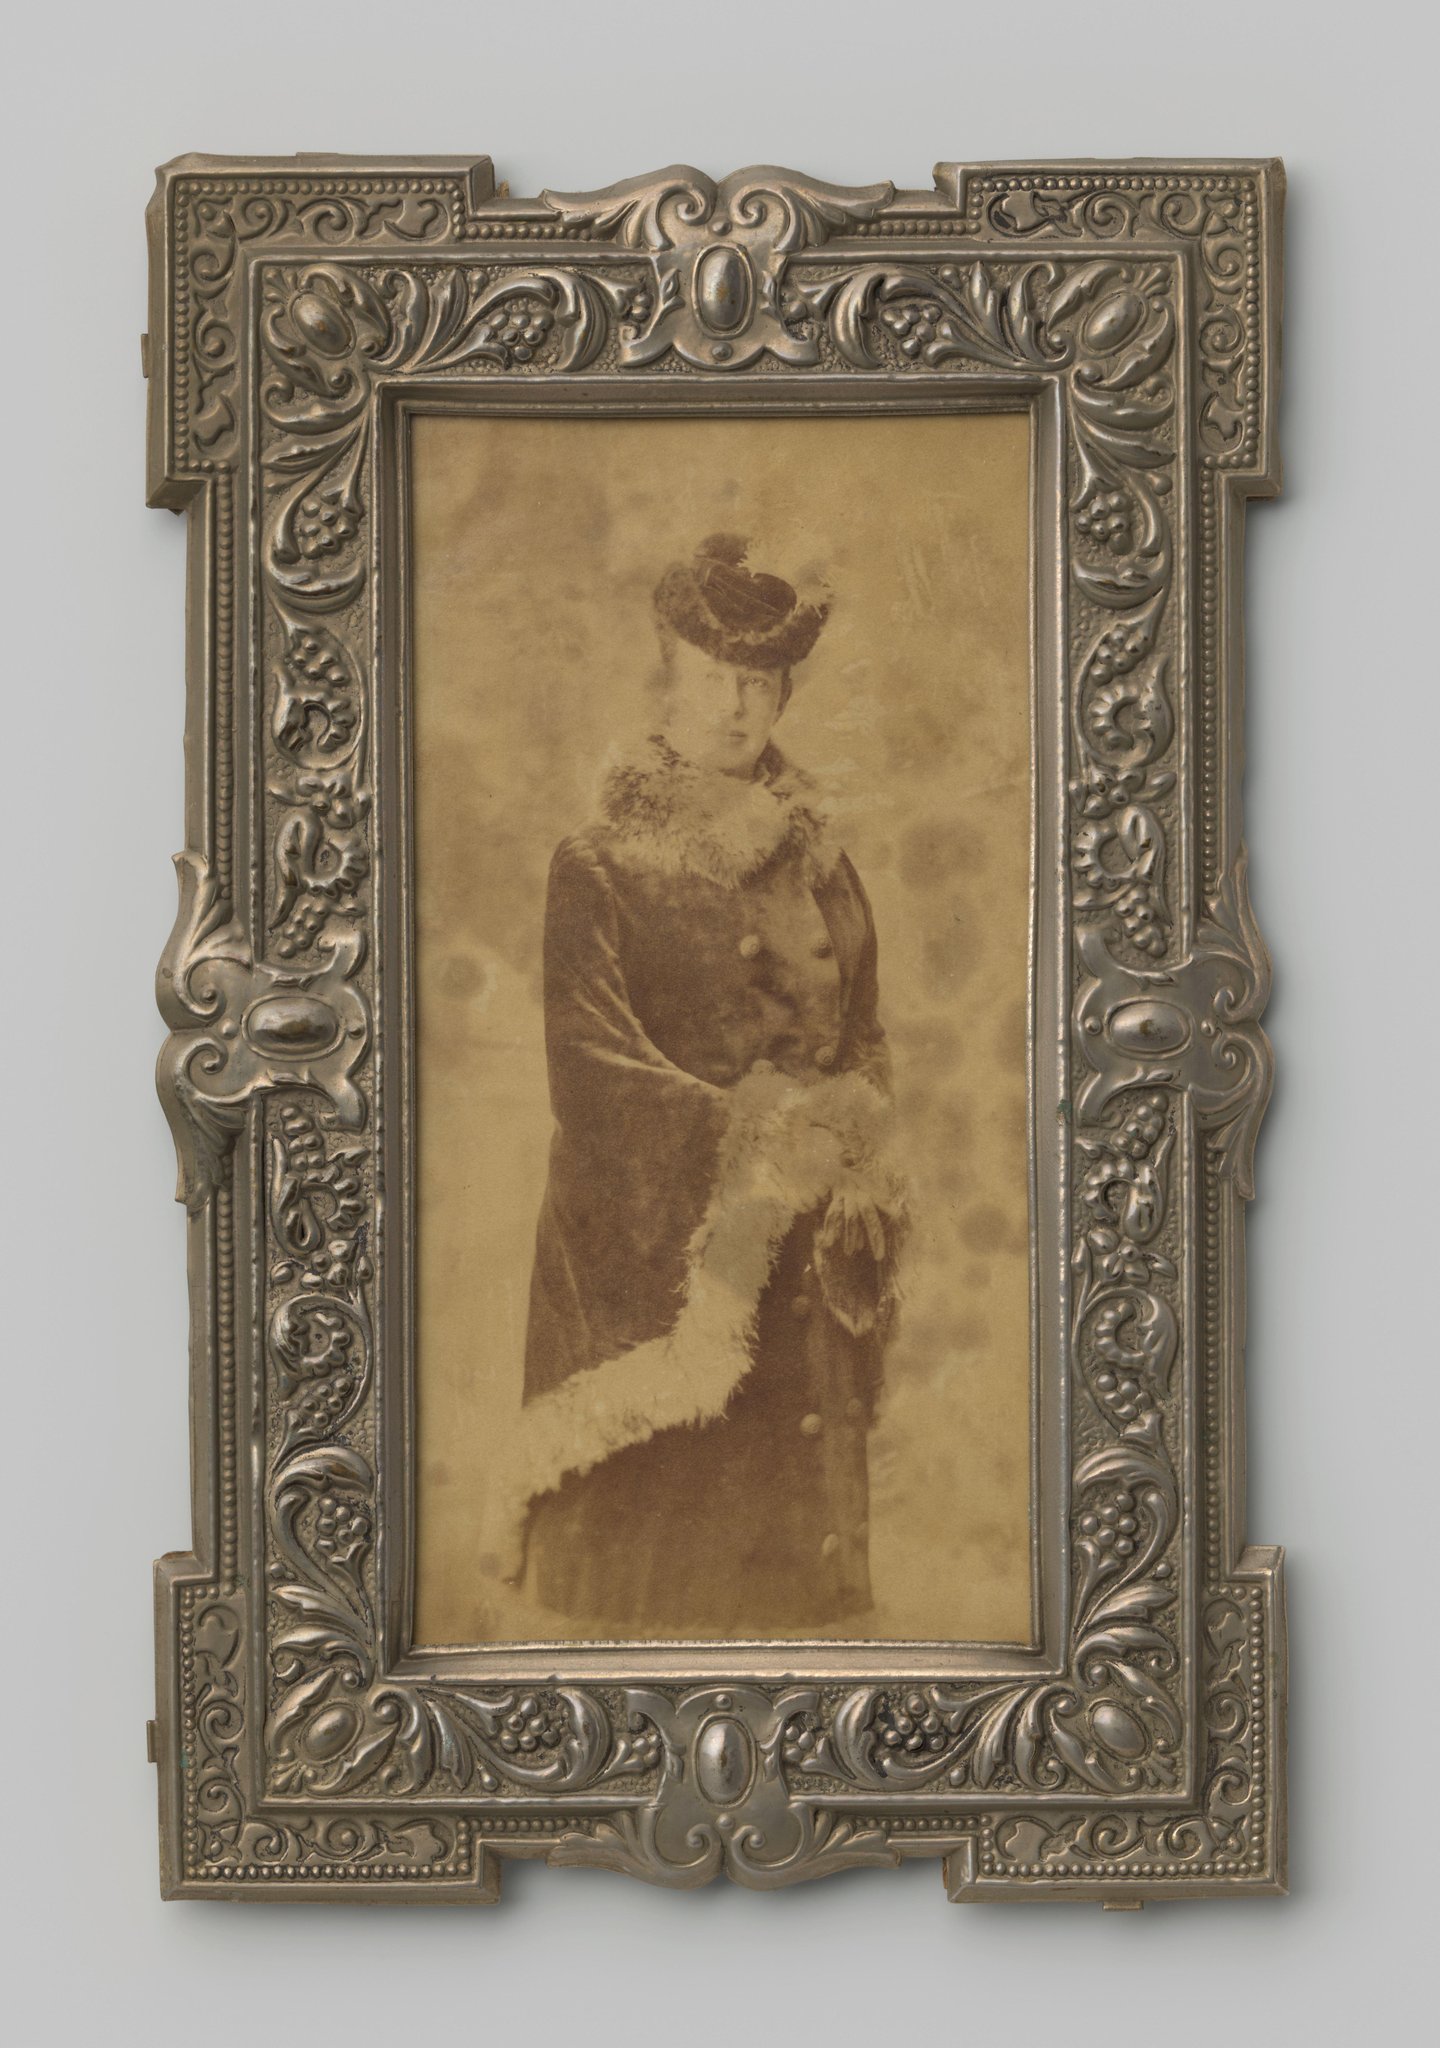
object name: frame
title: Portret van een onbekende vrouw in lange jas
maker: Anonymous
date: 1880-1900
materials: cardboard, glass, metal, paper, fiber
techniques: albumen print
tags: adult woman, coat, anonymous historical person portrayed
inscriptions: label: ‘H. Gijselman Antiques/ 355/7 VO/ 30,-/ Singel 118 - Amsterdam’